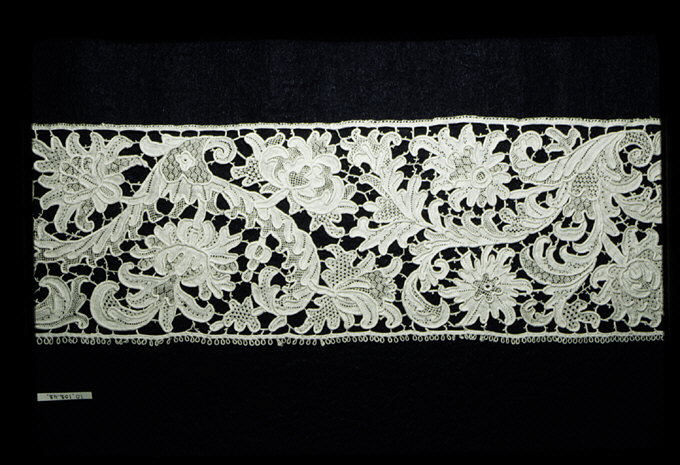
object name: border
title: Border (one of two)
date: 1801-1900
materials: lace, linen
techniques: gros point, lace